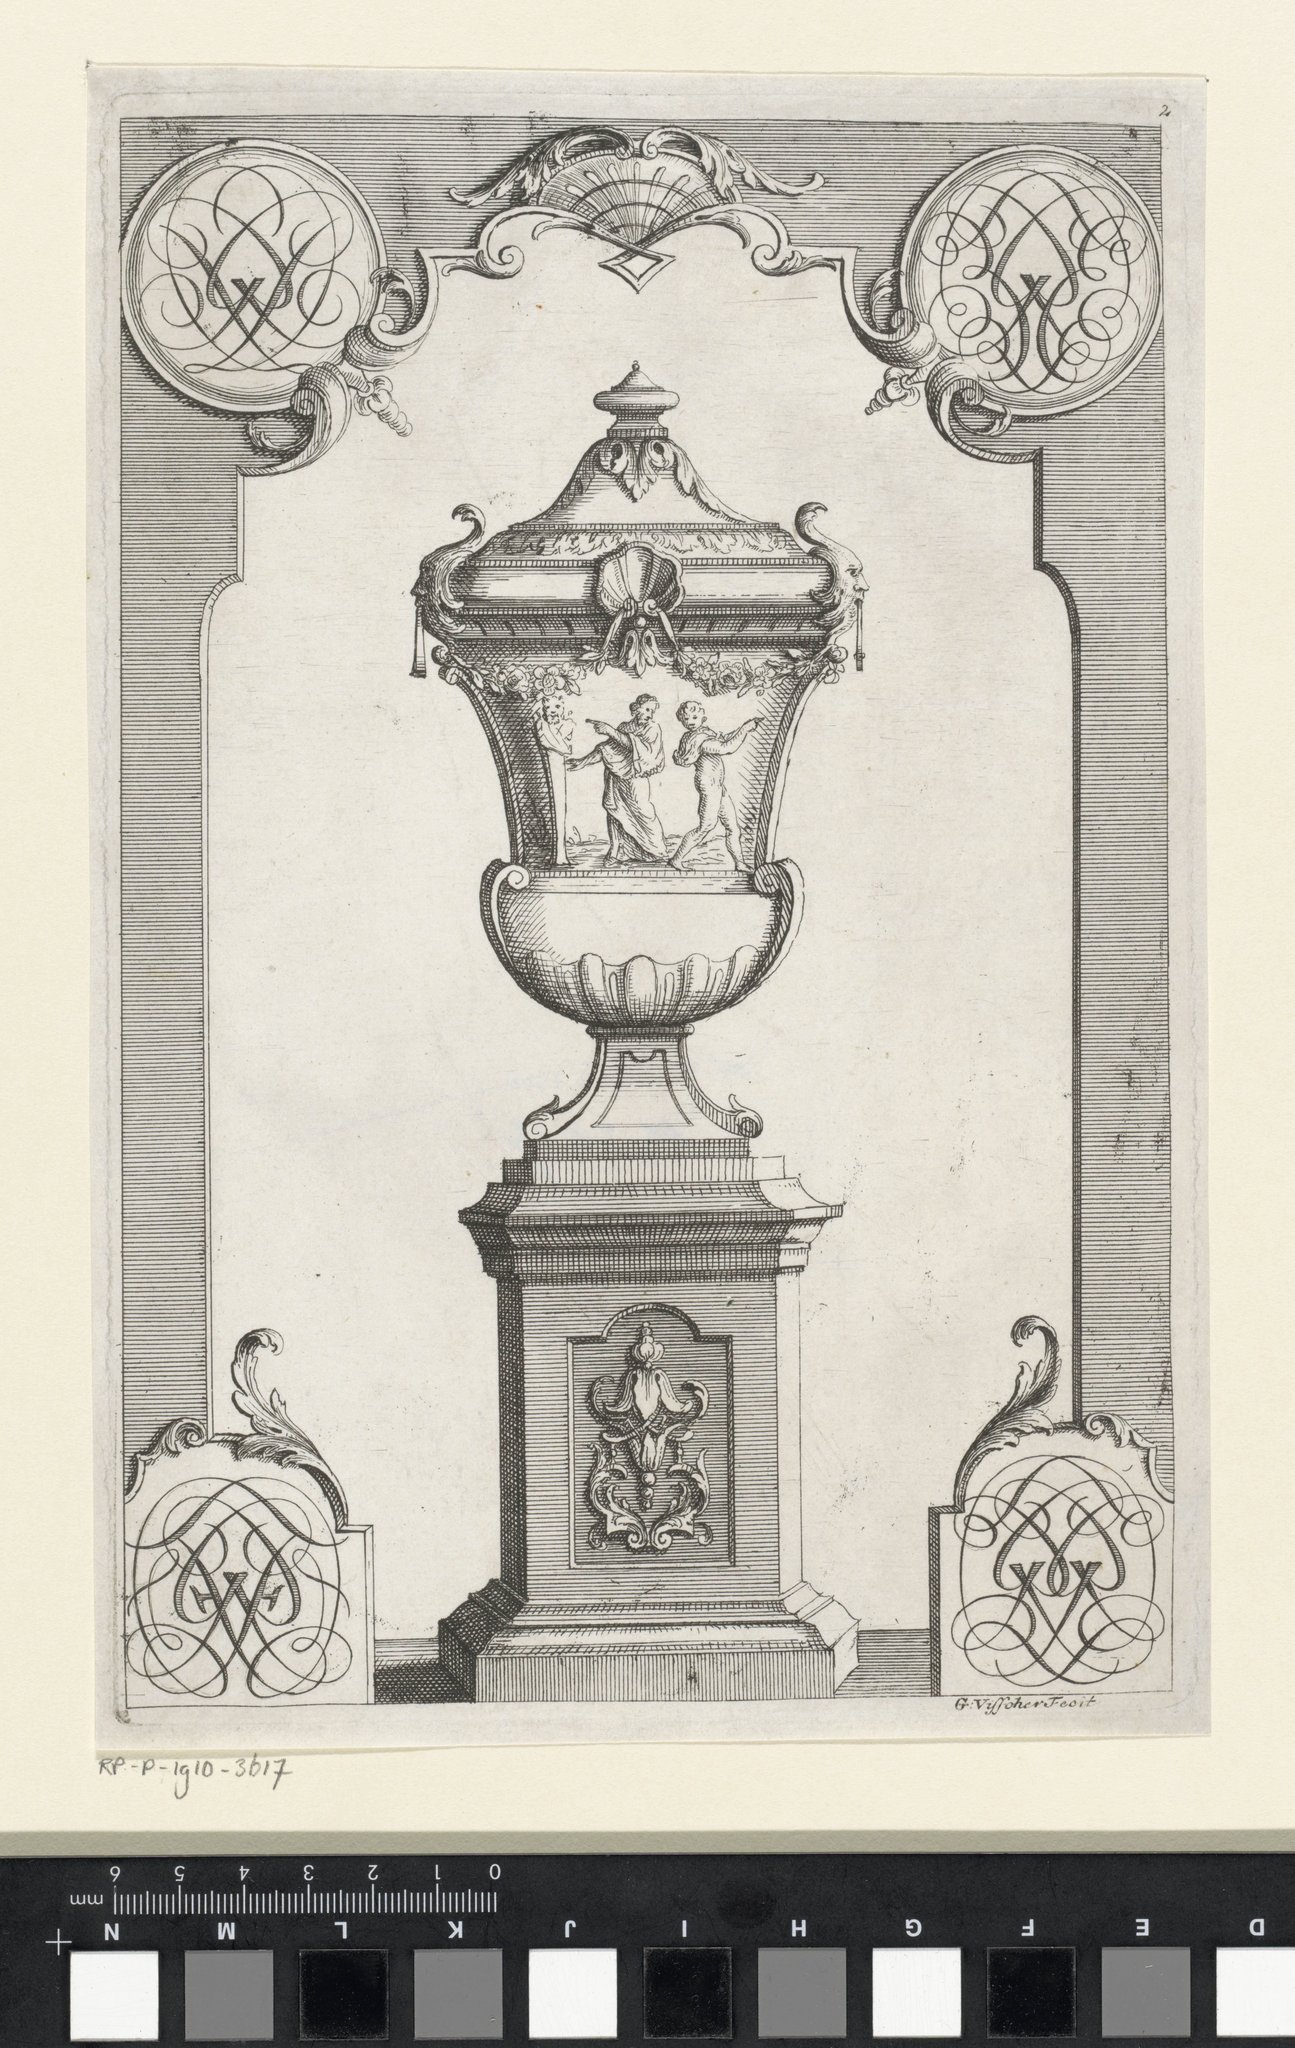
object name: print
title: Paneel met tuinvaas en in de hoeken monogrammen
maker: gerrit visscher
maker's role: print maker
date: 1690-1710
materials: paper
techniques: engraving, etching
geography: amsterdam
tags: ornaments ~ art, garden vase, letter combinations such as letterword, anagram, letter square, monogram, etc.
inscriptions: collector's mark: Lugt 2228